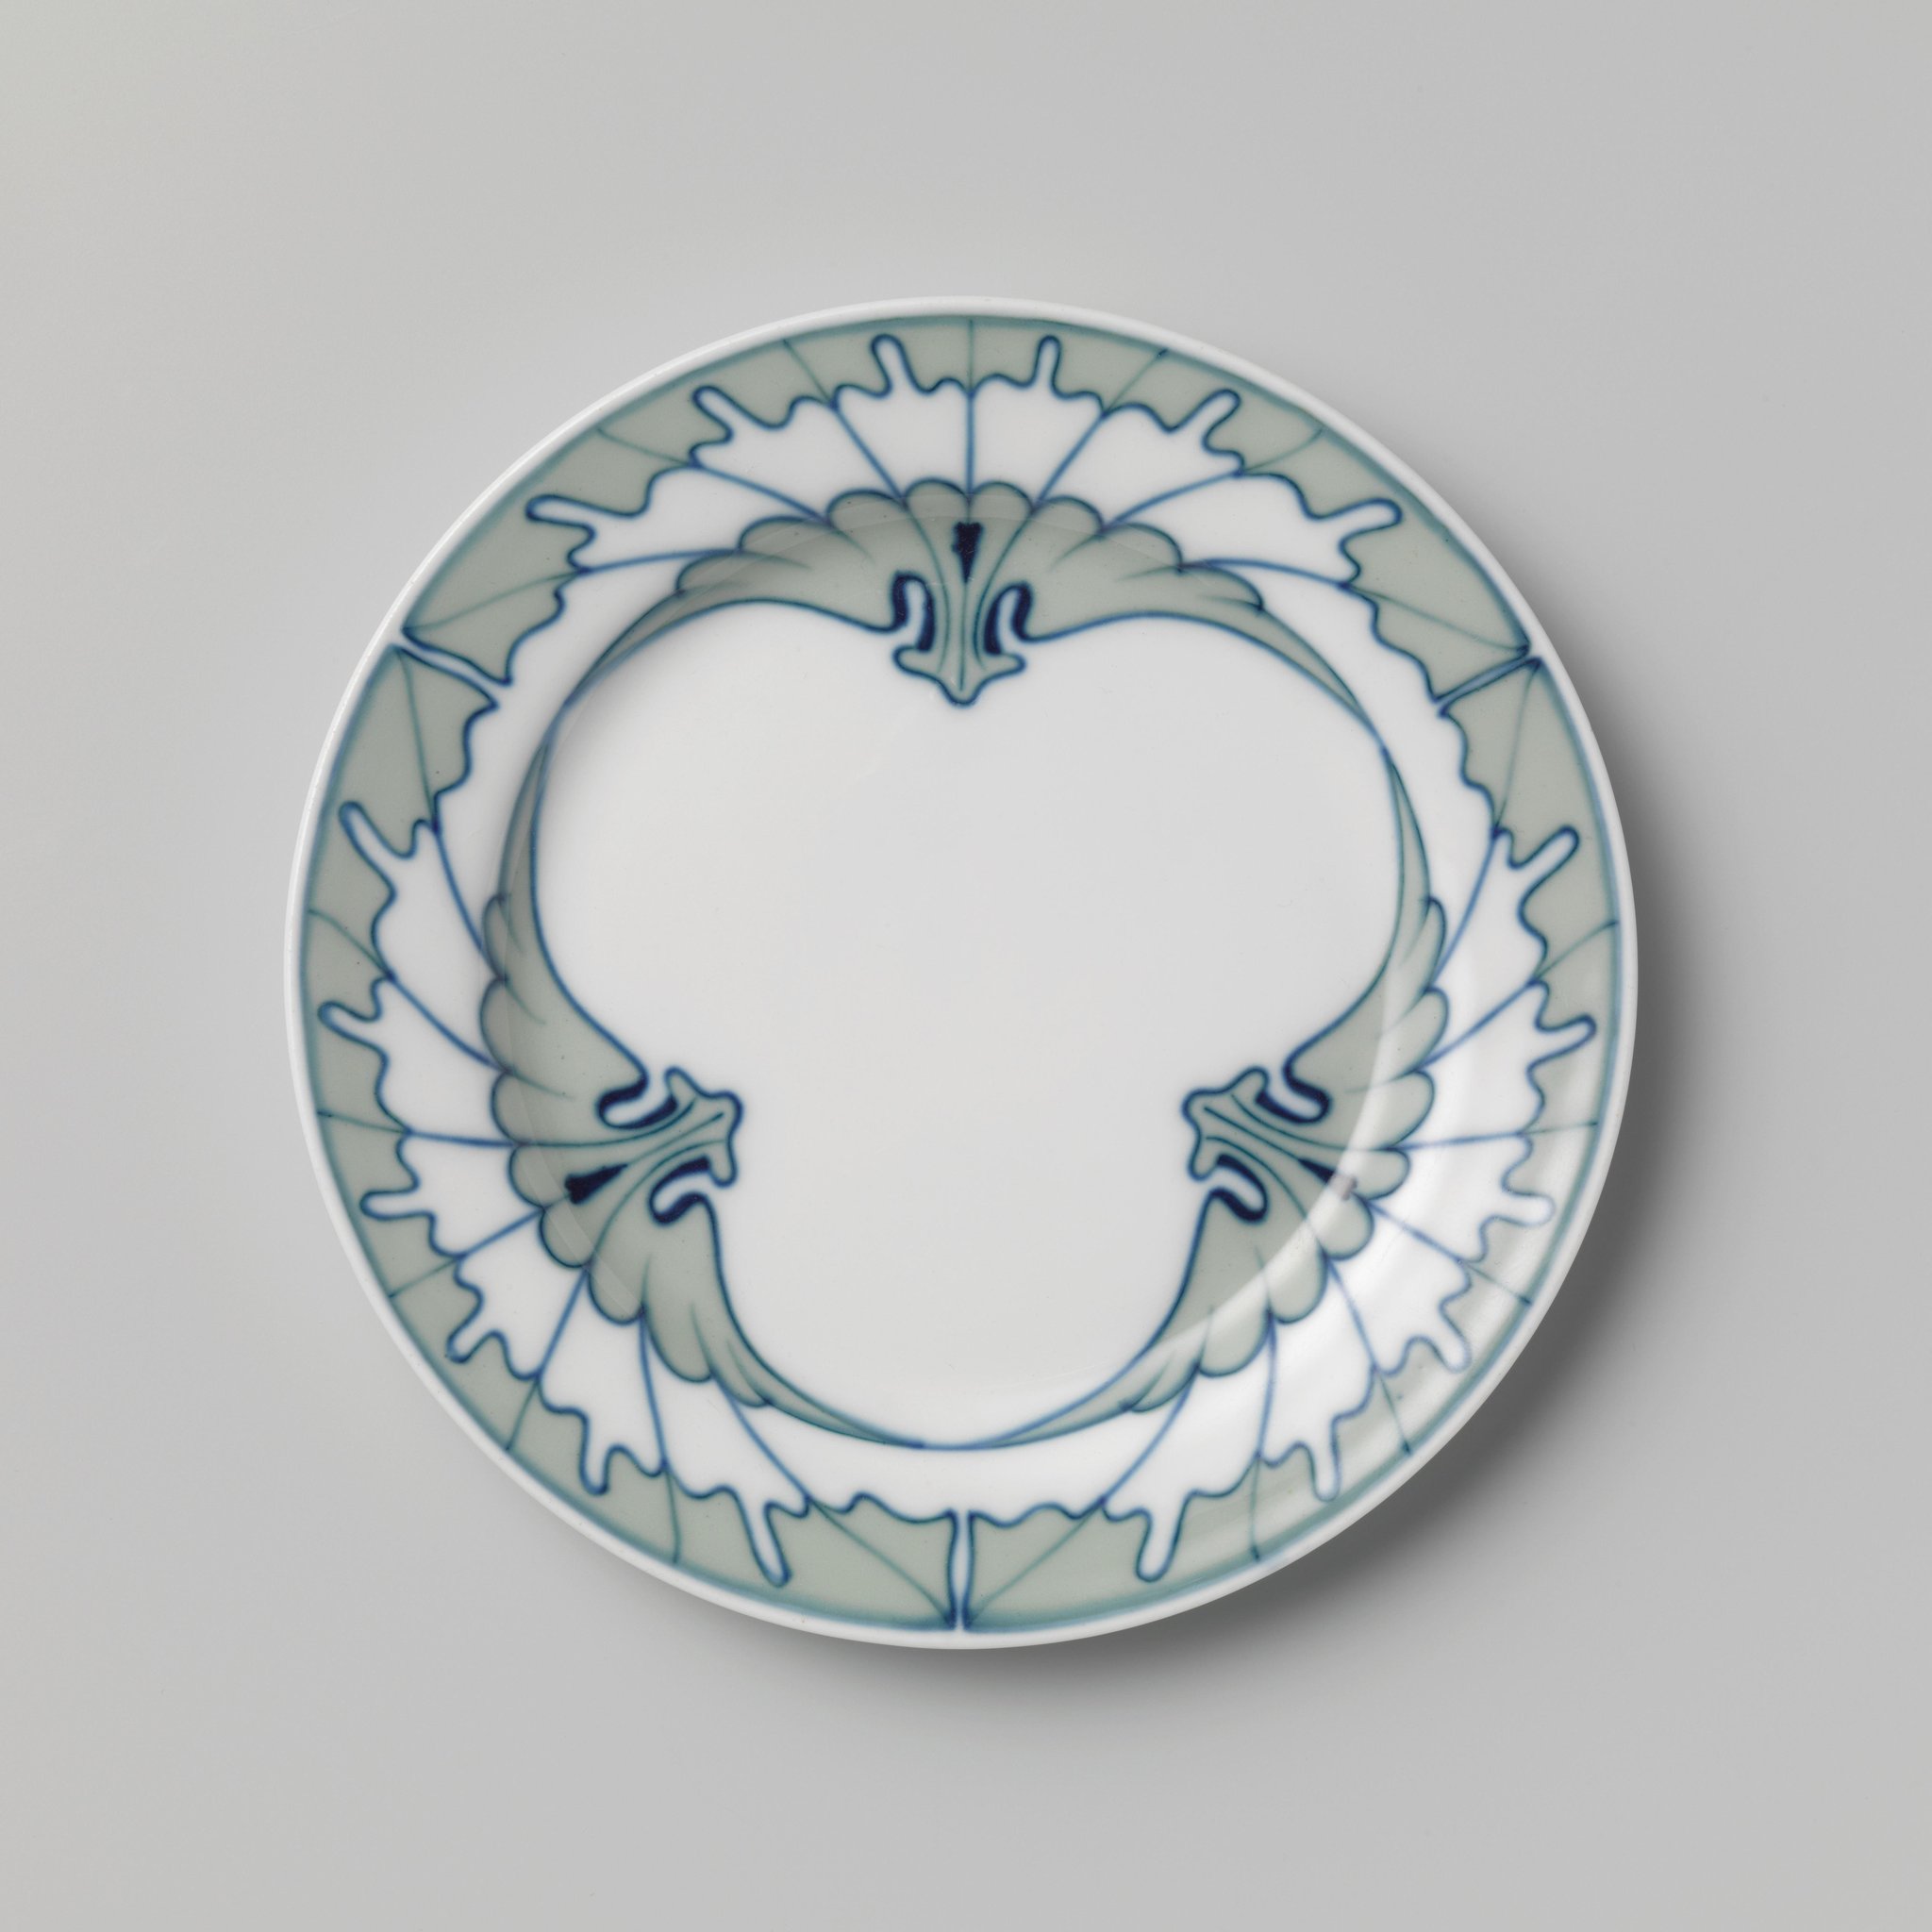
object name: plate dish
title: Bord, beschilderd met het Flügelmuster-decor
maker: konrad hentschel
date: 1901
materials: porcelain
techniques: painted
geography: meissen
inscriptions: factory mark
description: Bord van beschilderd porselein. Het bord is beschilderd in groen en blauw met het Flügelmuster. Het bord hoort bij een servies (BK-1976-65-1 t/m BK-1976-65-34) en is gemerkt.